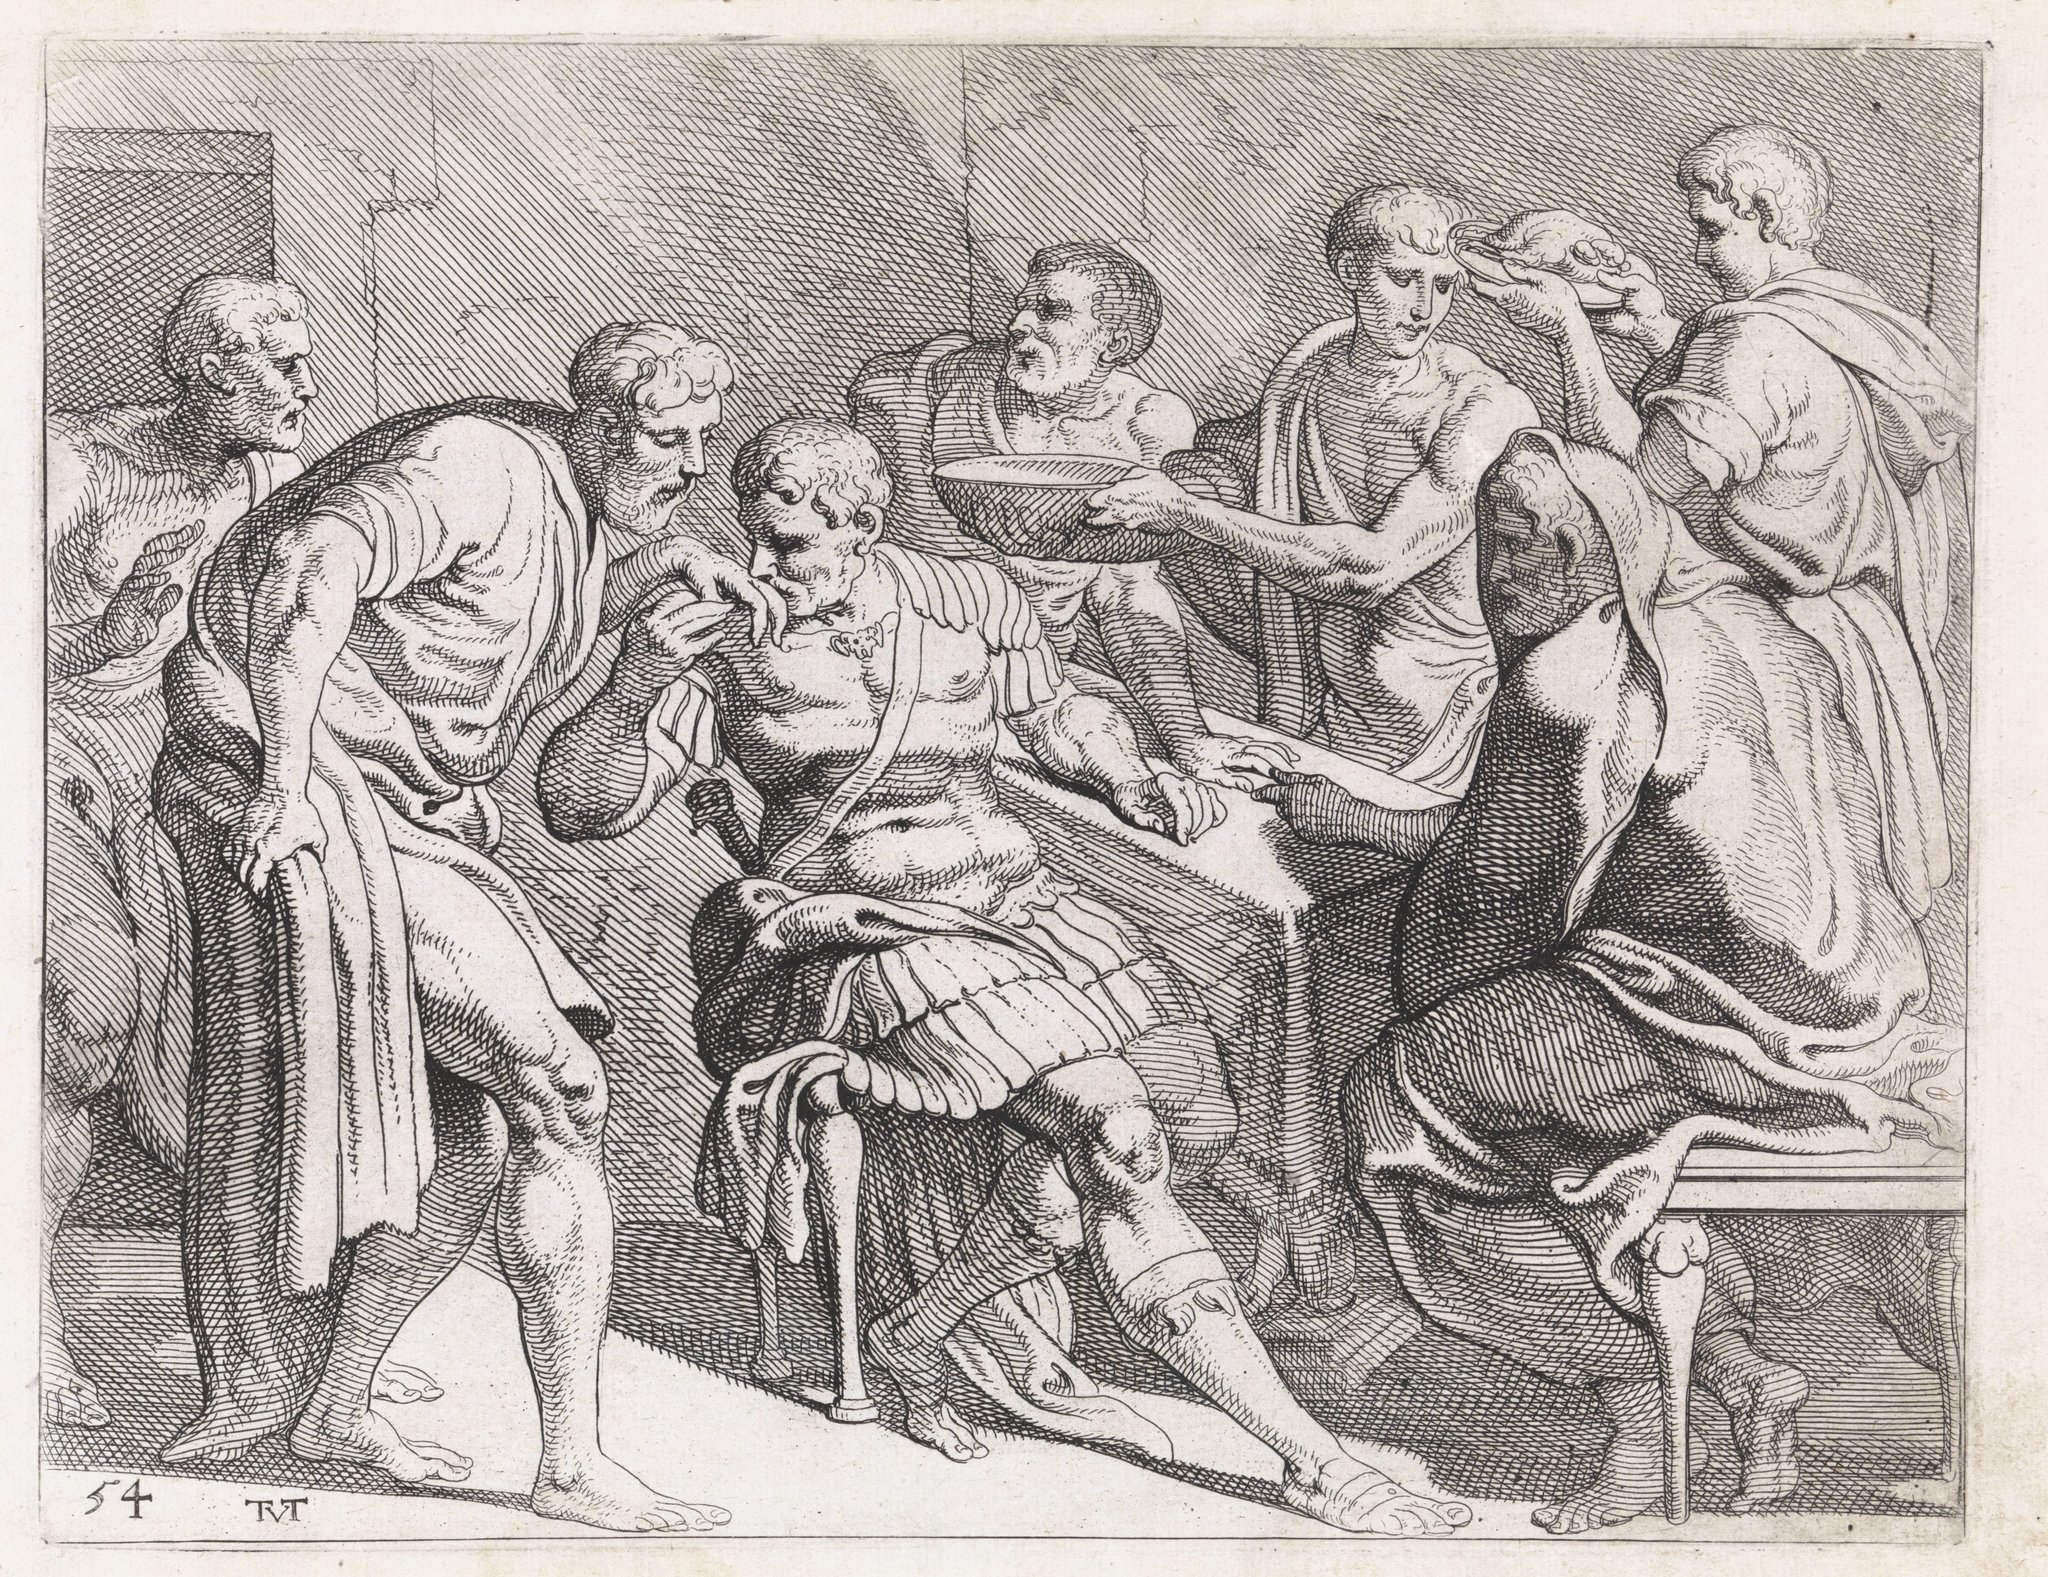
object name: print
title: Odysseus verwelkomt door Dolios en zijn zonen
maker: theodoor van thulden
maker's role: draughtsman, painter, print maker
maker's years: 1606-1669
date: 1632-1633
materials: paper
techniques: engraving, etching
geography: paris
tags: ulysses with his father laertes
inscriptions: collector's mark: Lugt 2228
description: Dolius laat zijn hand door Odysseus kussen als welkom, voordat ze aan de maaltijd gaan. Naast Odysseus zit zijn vader Laërtes.